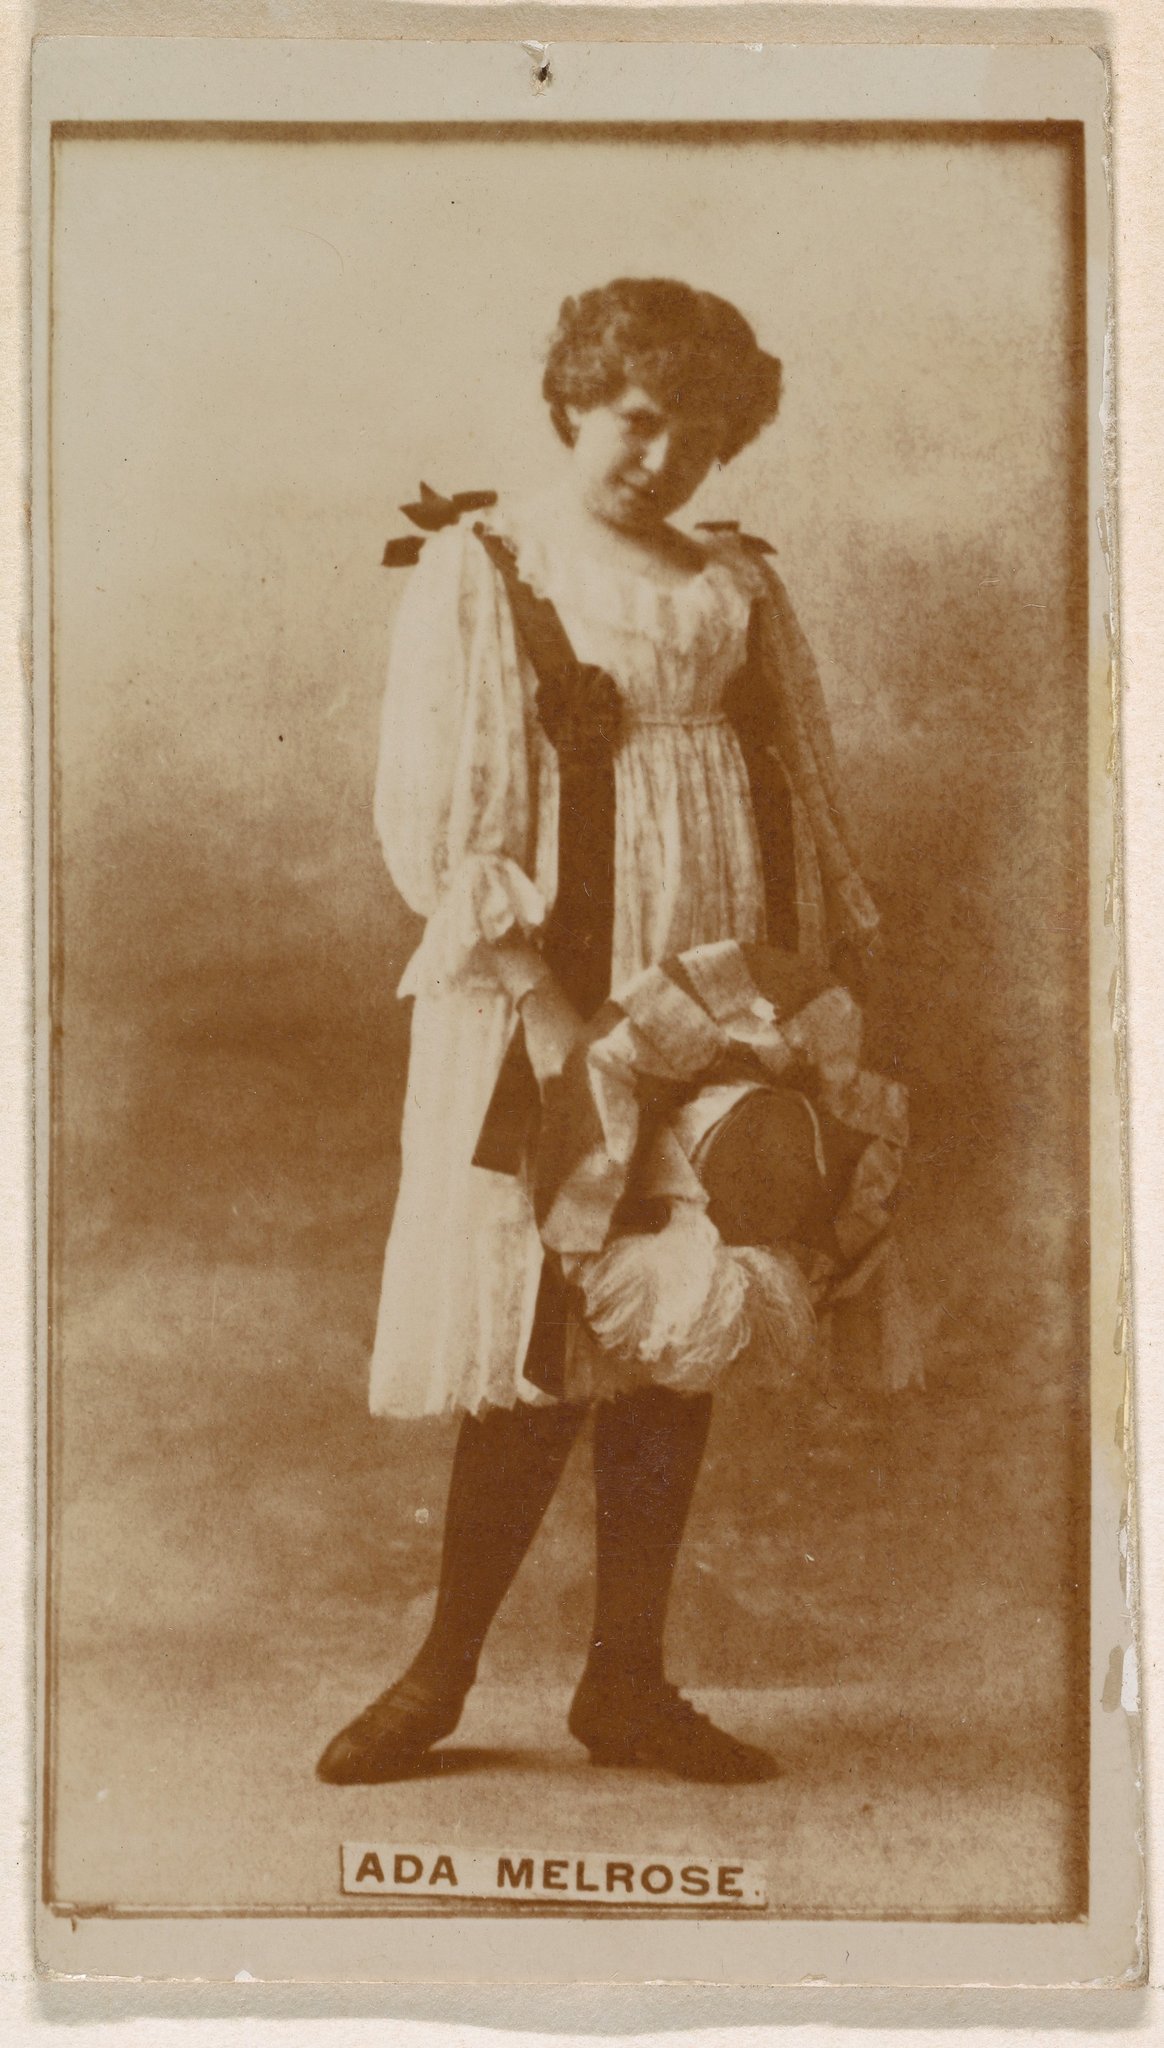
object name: photograph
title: Ada Melrose, from the Actresses series (N245) issued by Kinney Brothers to promote Sweet Caporal Cigarettes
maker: kinney brothers tobacco company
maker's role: publisher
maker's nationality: american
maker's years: 1869-2011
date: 1890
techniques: albumen silver print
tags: portraits,women,actresses